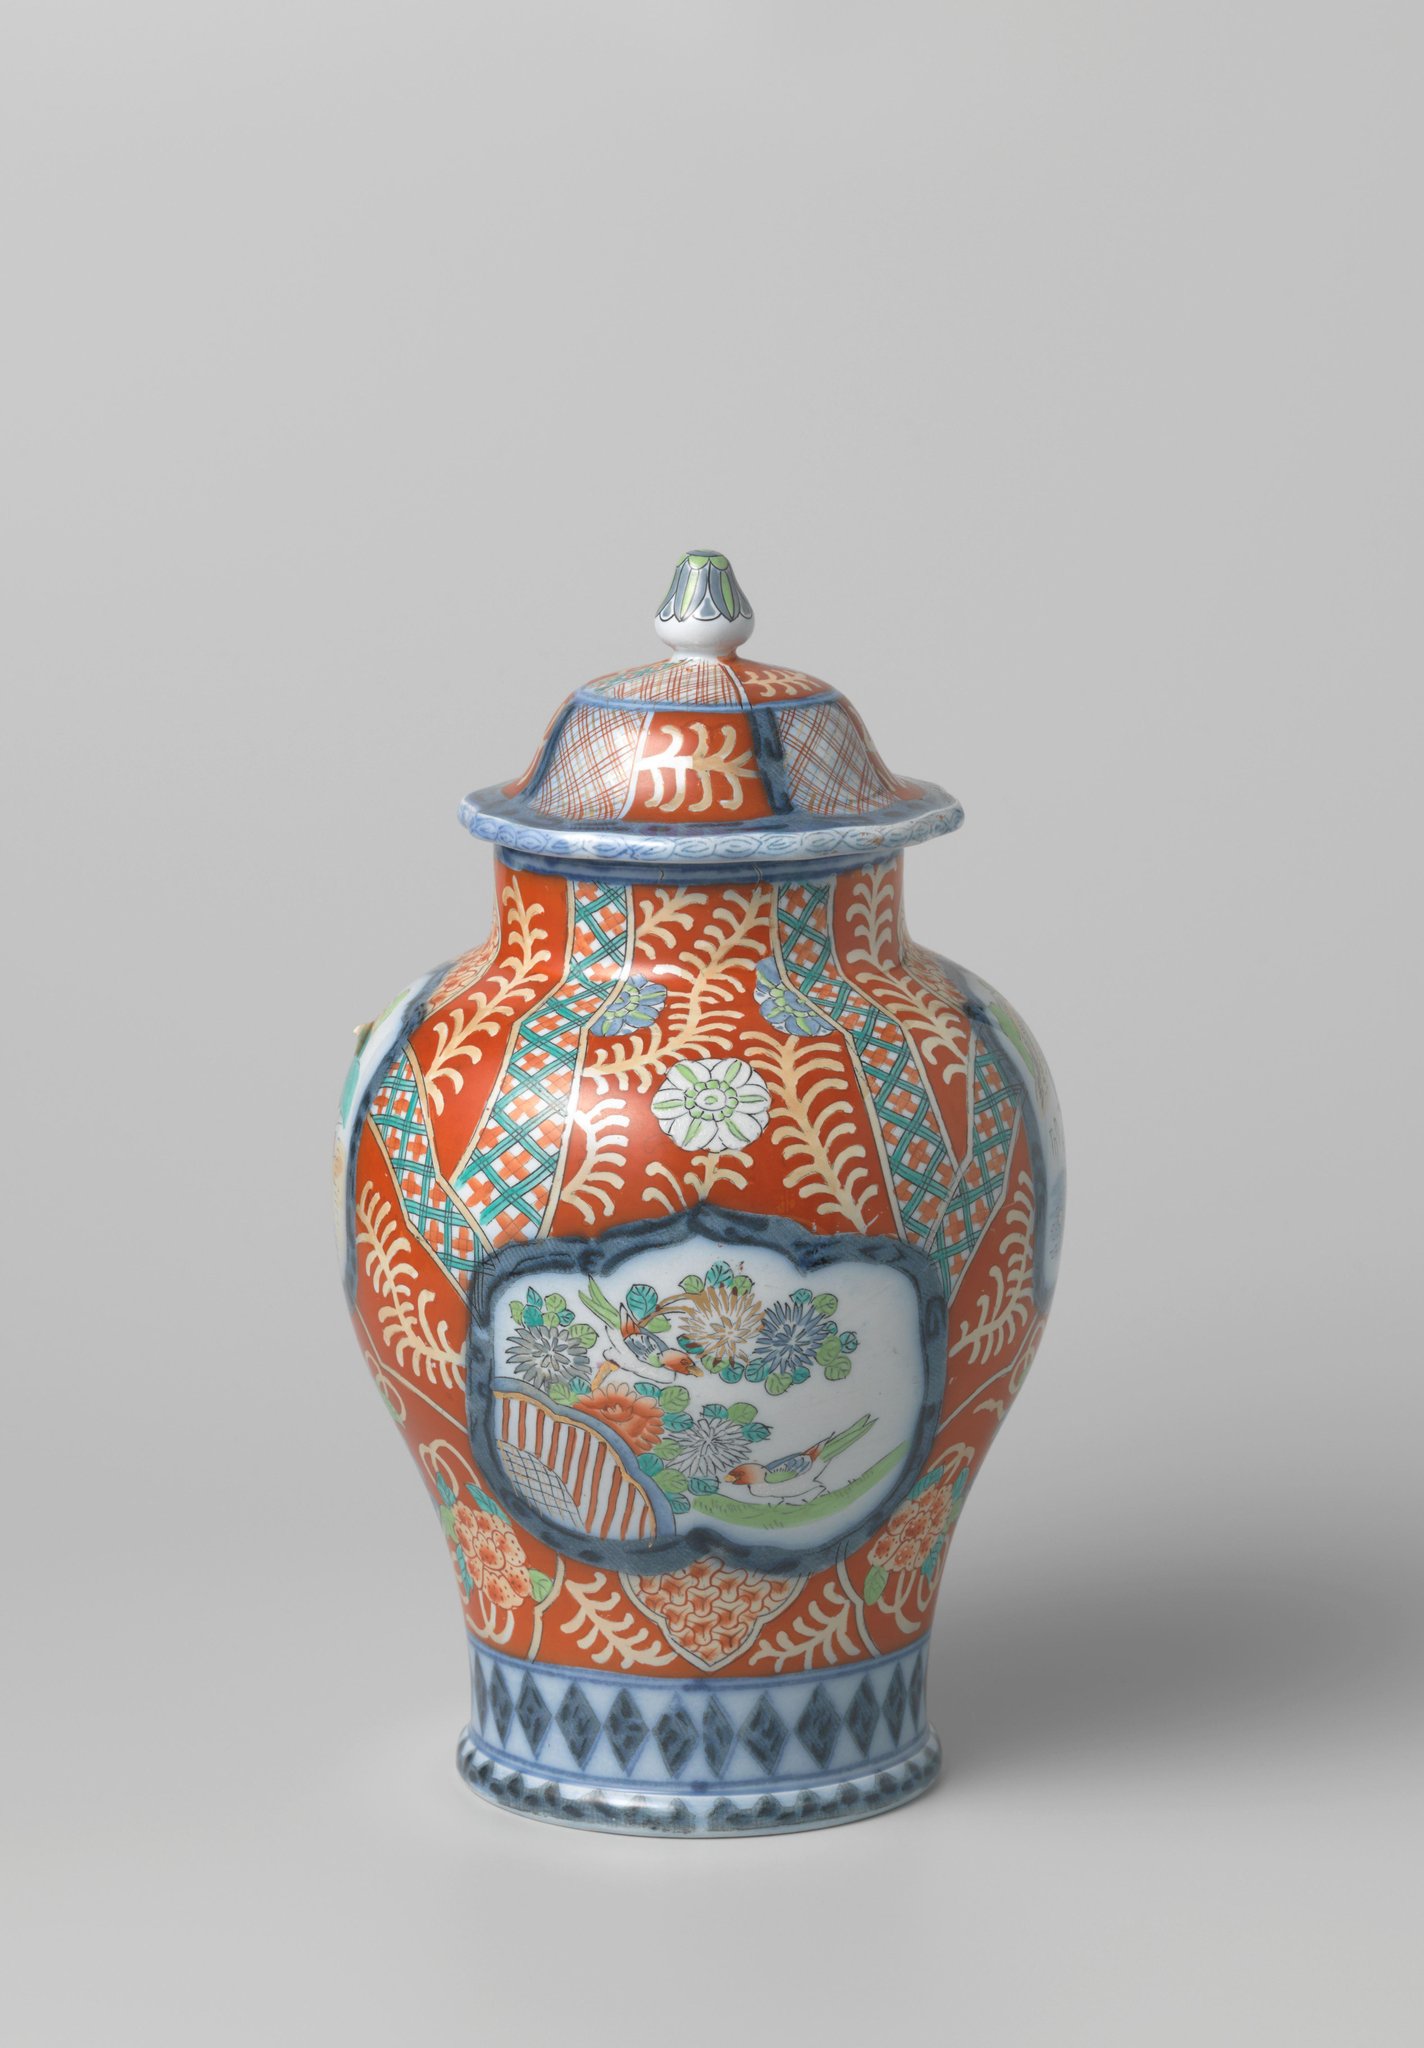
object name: lid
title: Deksel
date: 1886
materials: earthenware, glaze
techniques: vitrification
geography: maastricht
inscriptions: mark: ‘Sfinx // P. REGOUT & Co // MAASTRICHT’, check stamp: ‘3’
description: Deksel van aardewerk, beschilderd met emailkleuren en okerluster, met goud gehoogd. Een peervormige knop met bladmotieven beschilderd.